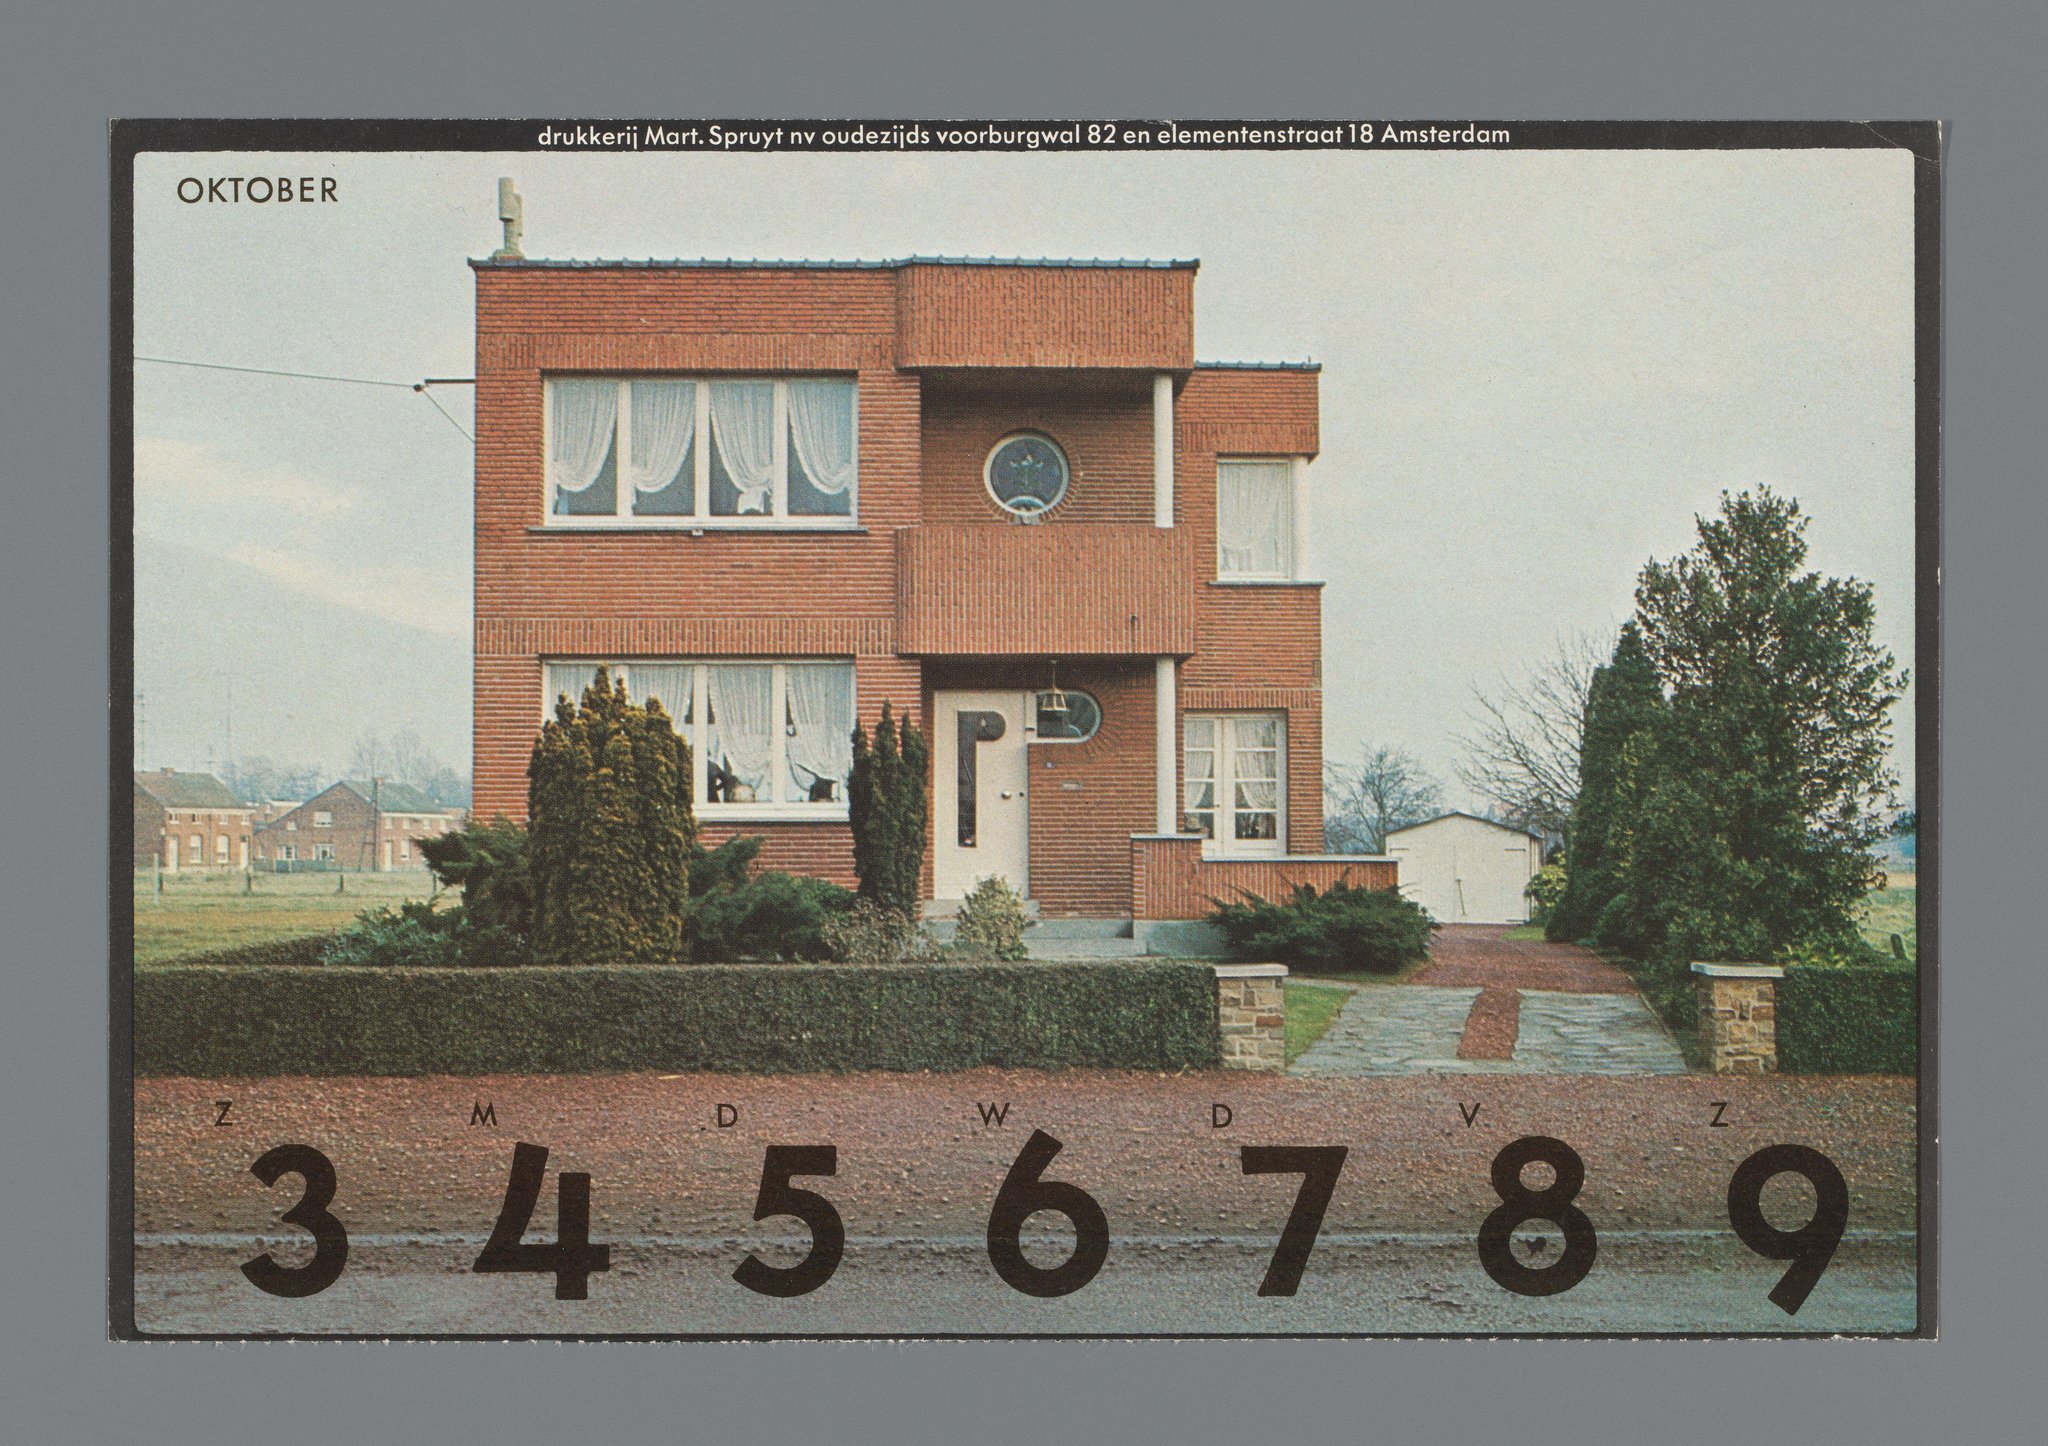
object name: photograph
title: België. Huizen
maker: Anonymous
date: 1900-1950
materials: paper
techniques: offset printed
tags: belgium